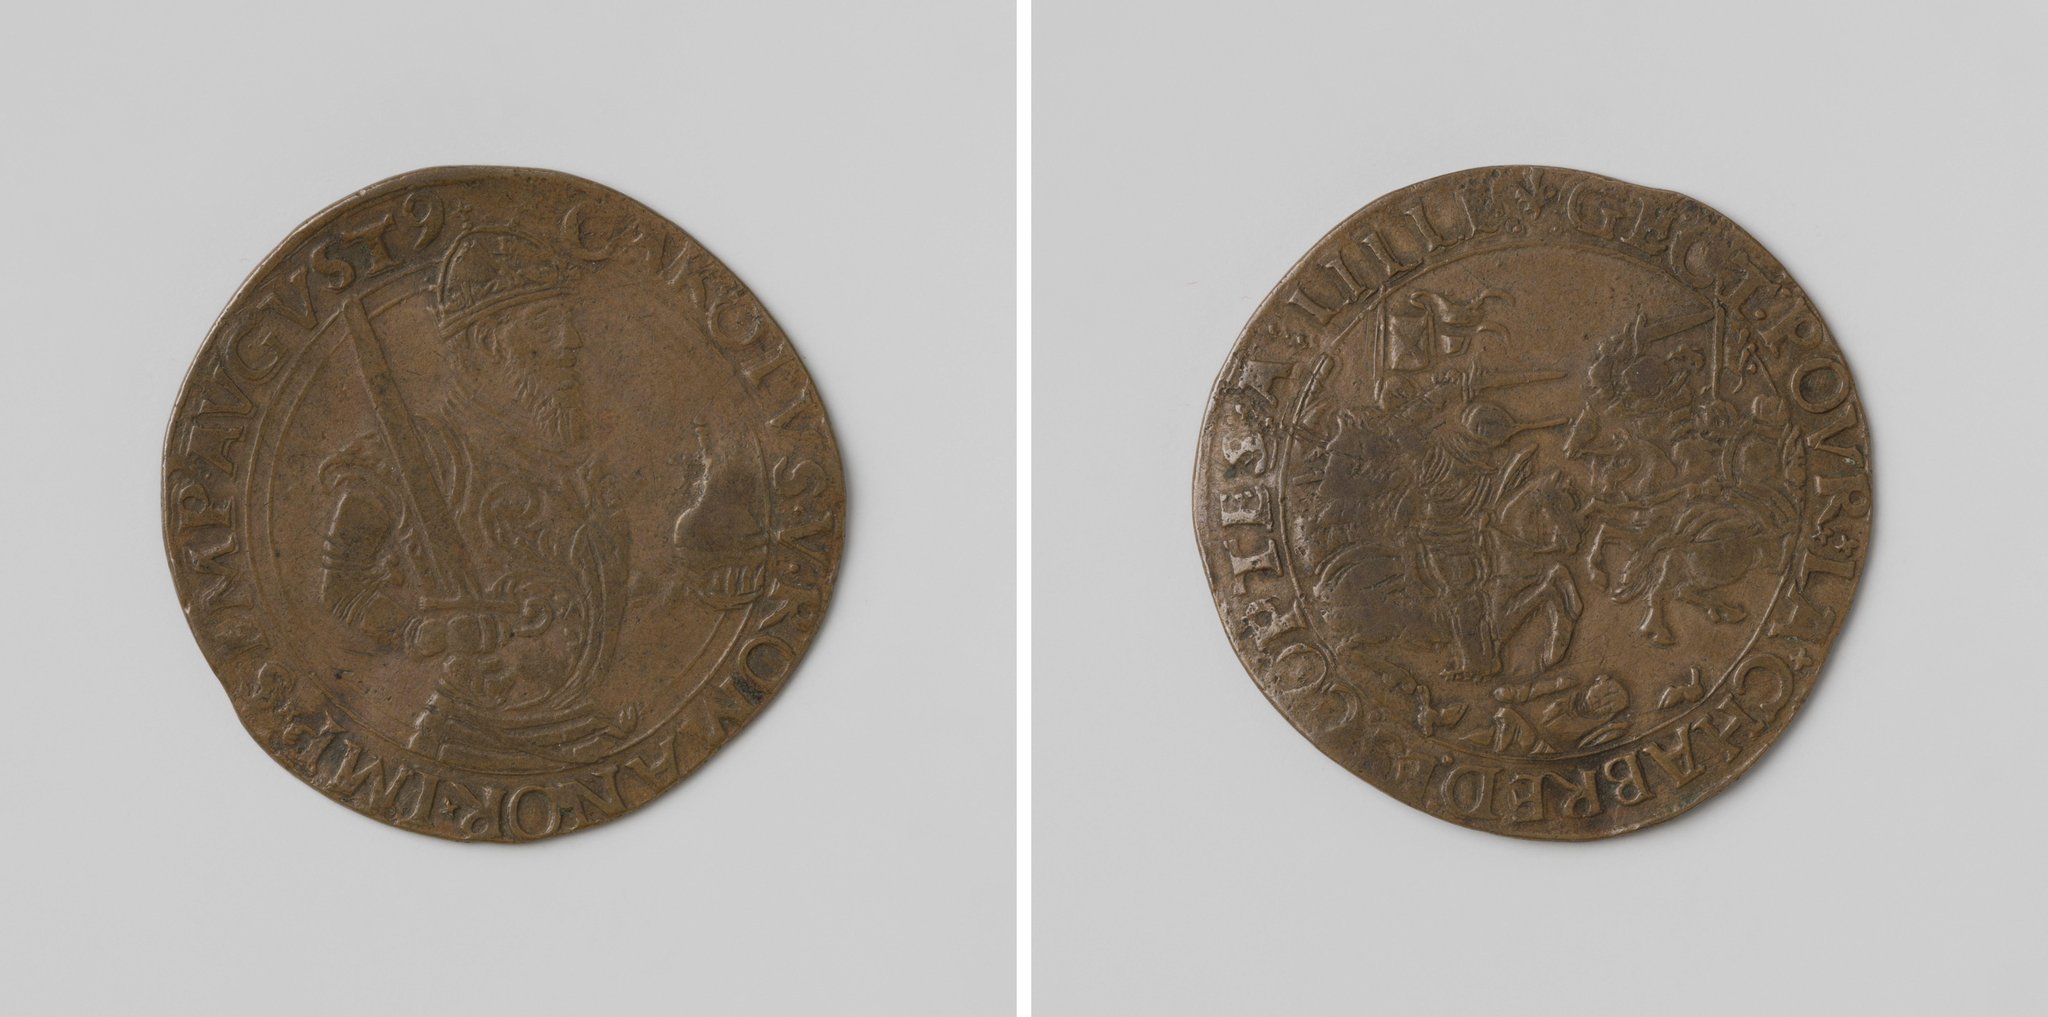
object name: jeton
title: Engels-Franse oorlog, penning van de rekenkamer van Vlaanderen te Rijssel, ter ere van Karel V, Duits keizer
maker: Anonymous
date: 1543-1546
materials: copper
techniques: striking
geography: flanders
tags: ghent, charles v (holy roman emperor and king of spain), lille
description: Koperen penning. Voorzijde: portret van Karel V met kroon, rijksappel in linkerhand en zwaard over rechterschouder binnen omschrift. Keerzijde: ruitergevecht binnen omschrift